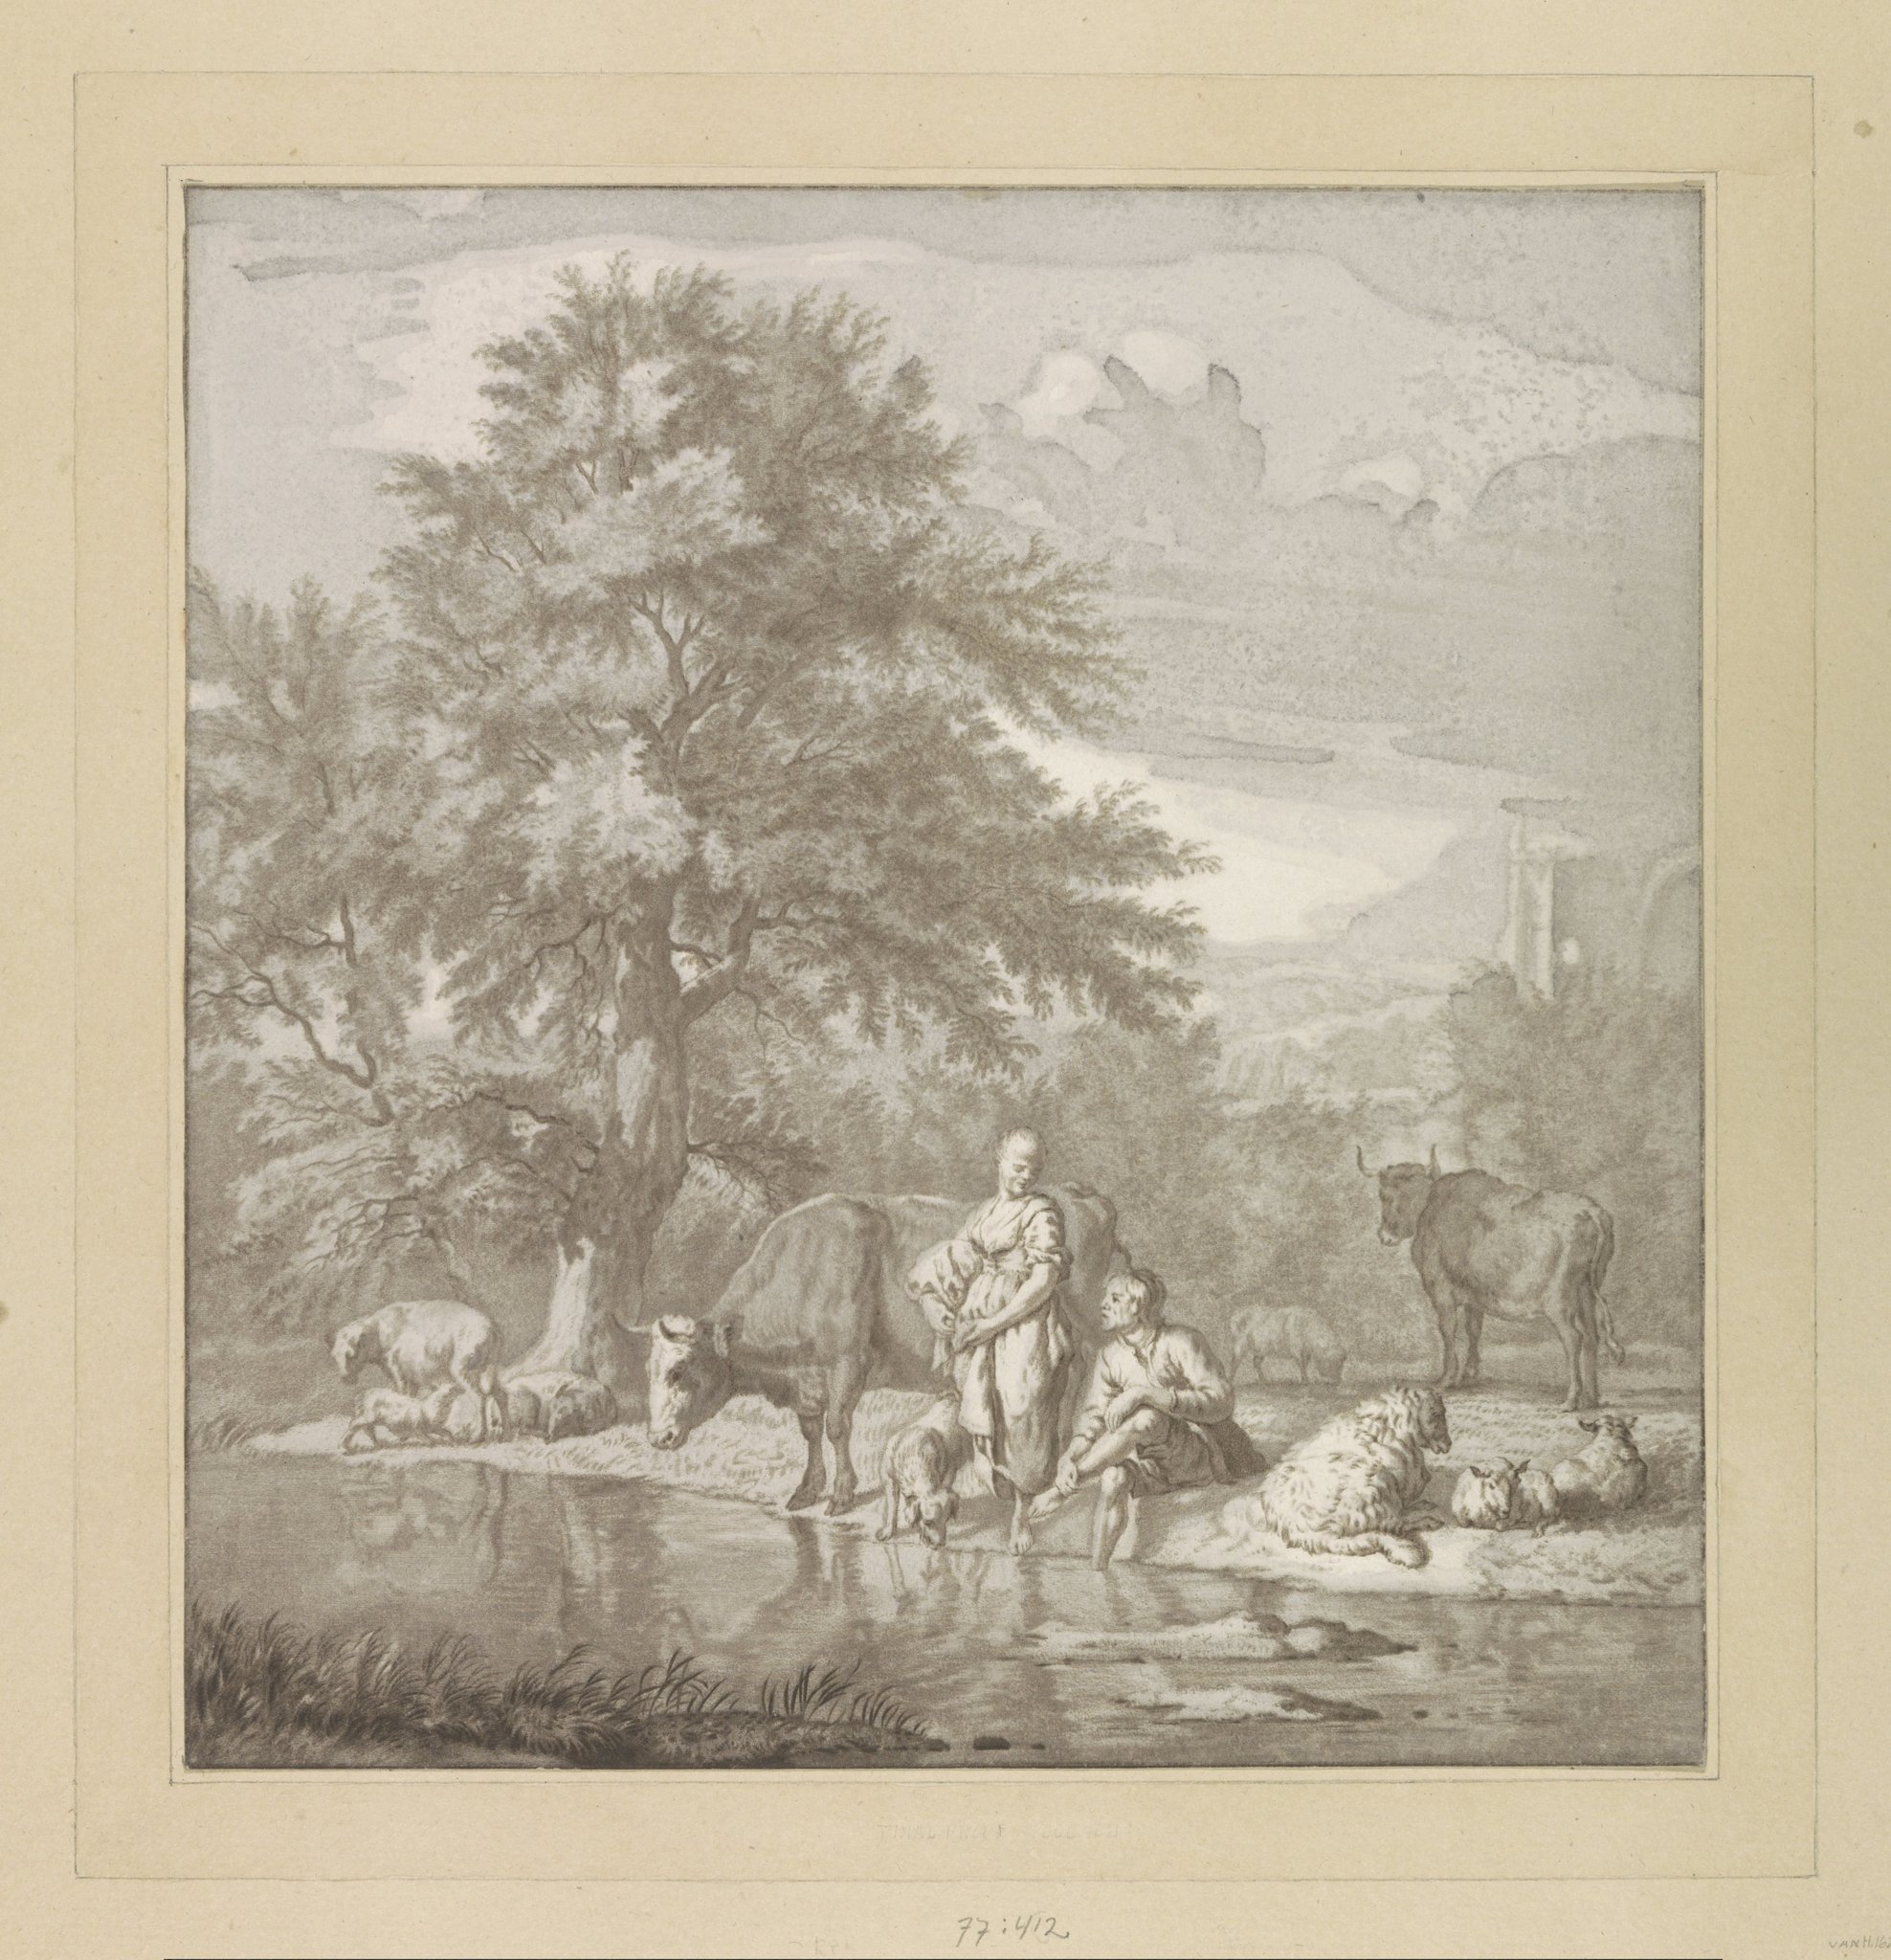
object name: print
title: Herders en herderin met kudde bij rivier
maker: cornelis ploos van amstel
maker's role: draughtsman, print maker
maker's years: 1726-1798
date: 1763-1765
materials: paper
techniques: printmaking, etching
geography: amsterdam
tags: cow, herding, herdsman, herdswoman, shepherd, shepherdess, cowherd, etc., sheep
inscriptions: collector's mark: Lugt 2228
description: Een herder en een herderin staan op de oever van een rivier met hun schapen en koeien.